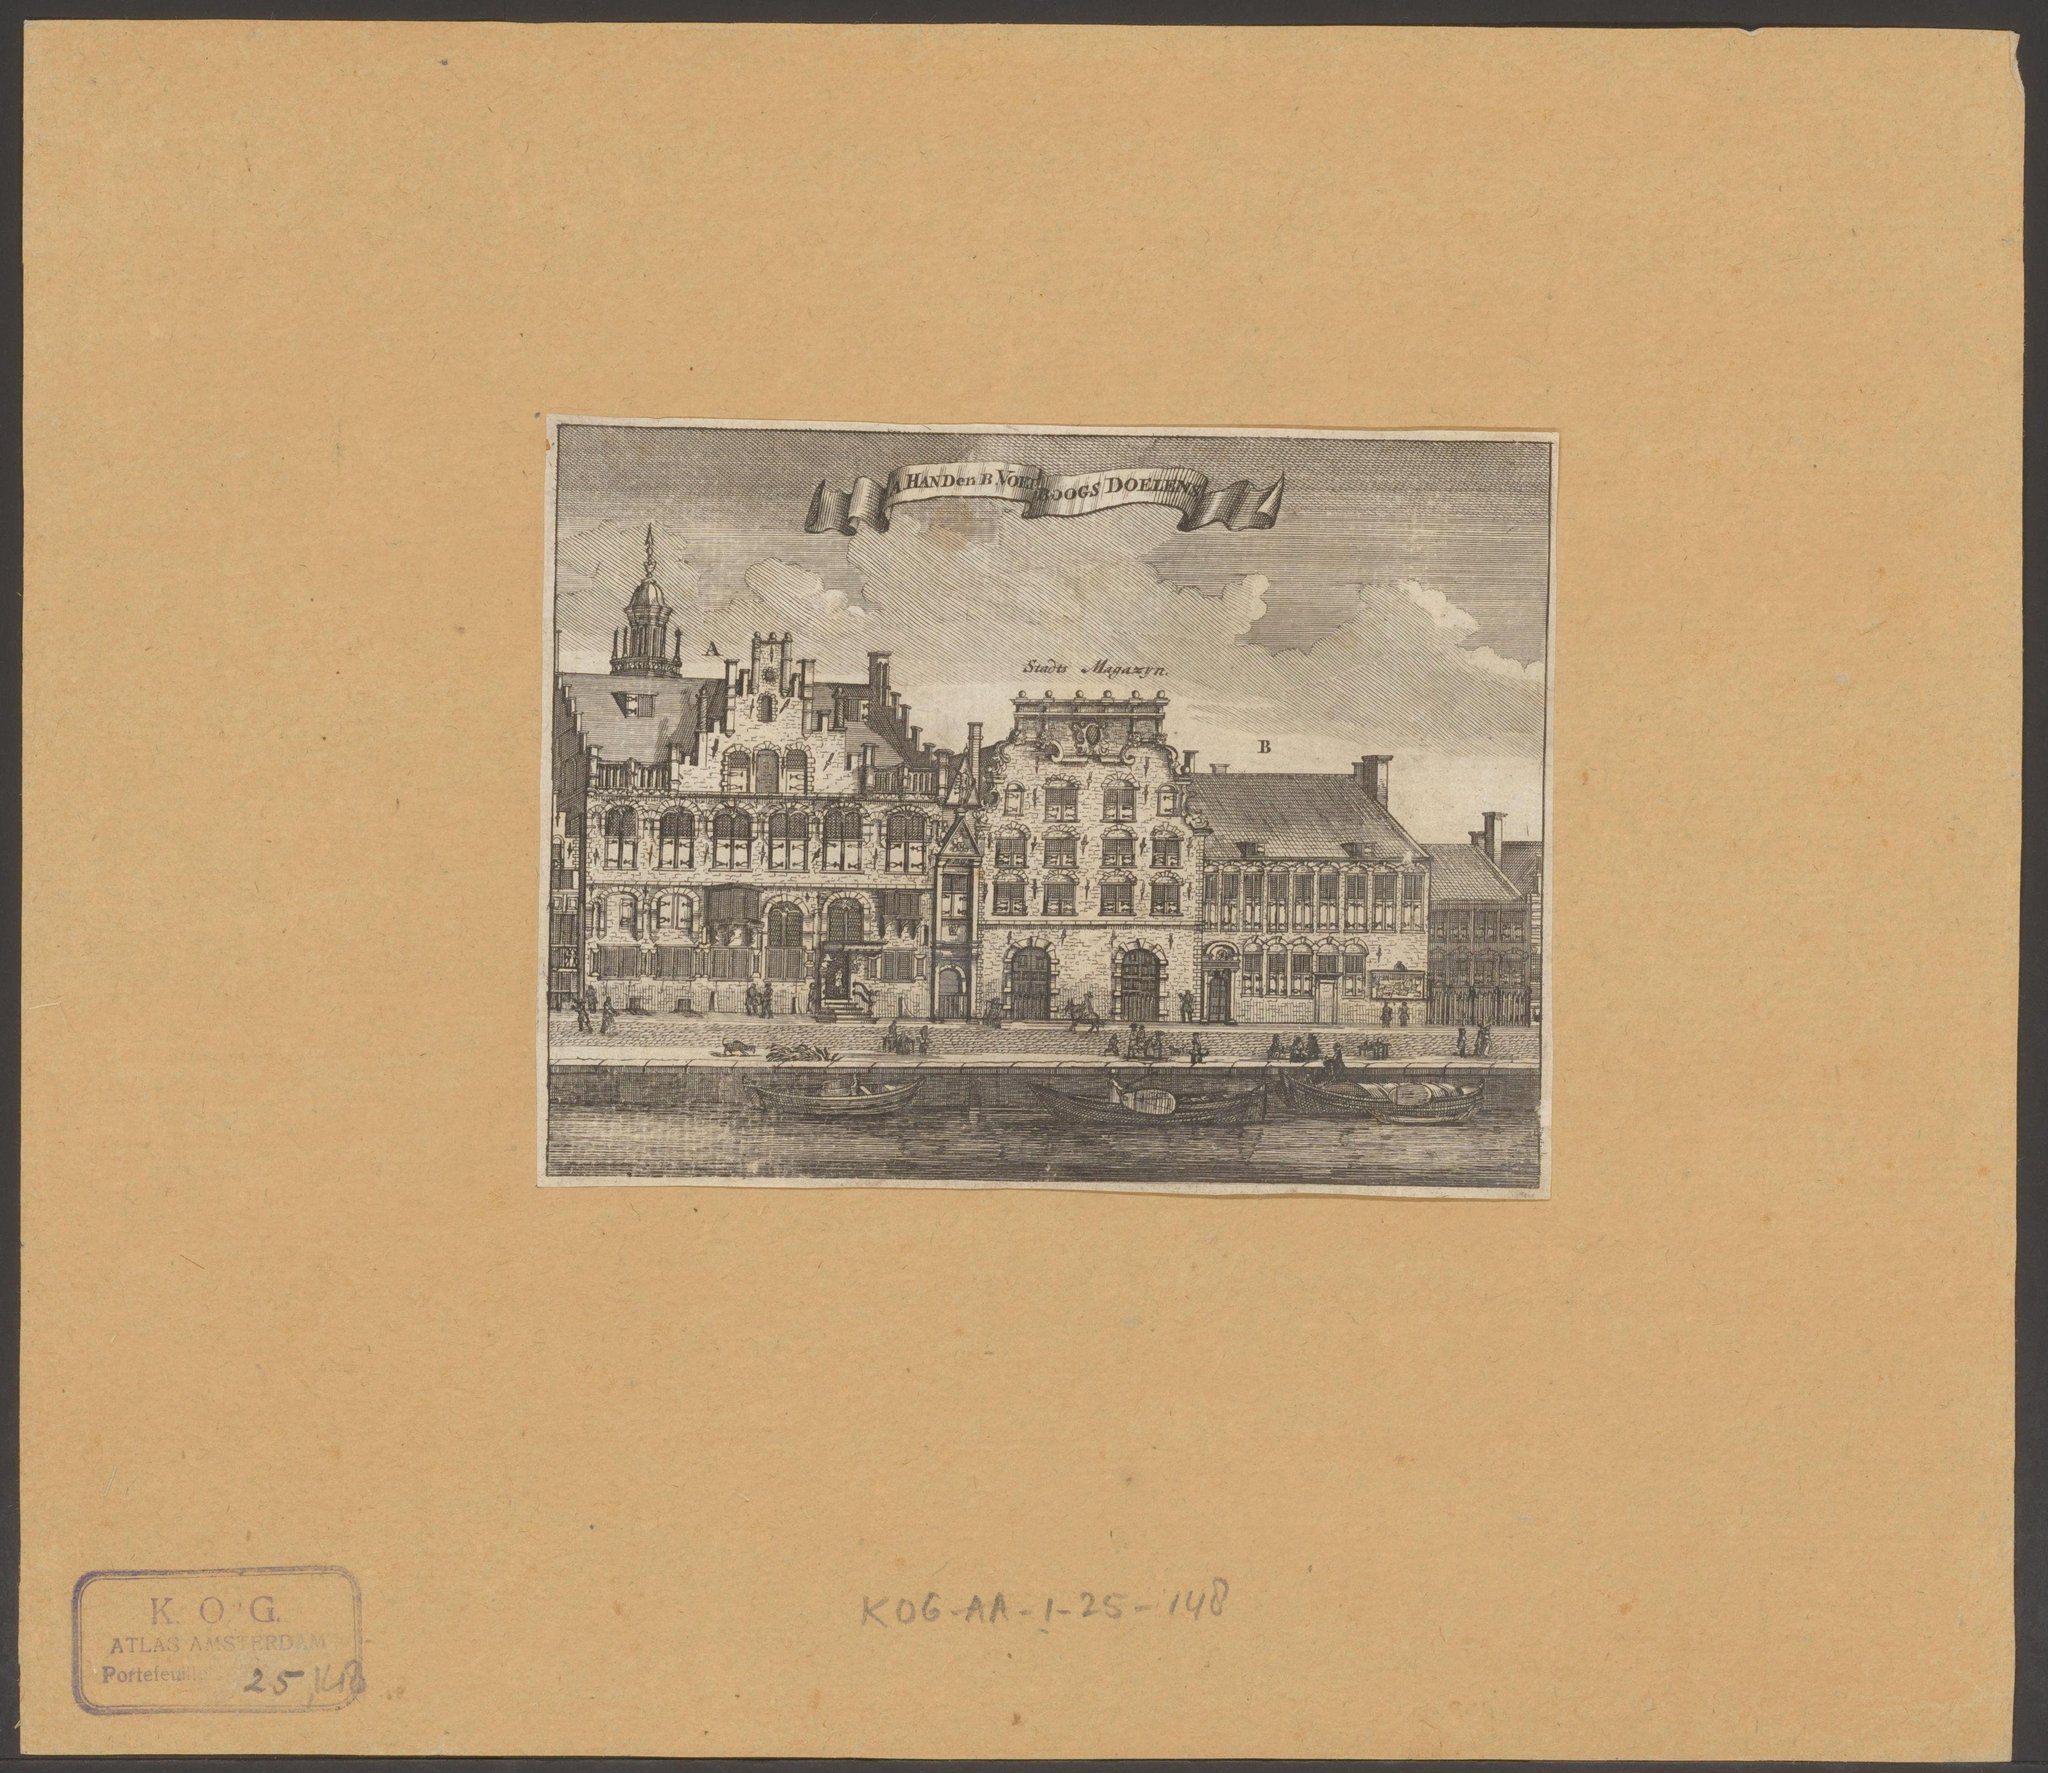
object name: print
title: A. Hand en B. Voetboogs Doelens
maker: Anonymous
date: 1693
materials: paper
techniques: etching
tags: city-view in general; 'veduta', canals, waters (in city), façade (of house or building), civic architecture; edifices; dwellings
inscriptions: collector's mark: ‘25.148’ Lugt 1641b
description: Eerdere staat van deze prent verschenen in: Commelin, Caspar. Beschryvinge van Amsterdam, desselfs eerste oorspronk uyt den Huyse der Heeren van Aemstel en Aemstellant (...). dl. 2. Amsterdam: Abraham Wolfgang, Gillis Janssonius van Waesberge, Johannes Janssonius van Waesberge II, weduwe Dirk Boom I, Hendrick Boom en Rembertus Goethals, 1693.